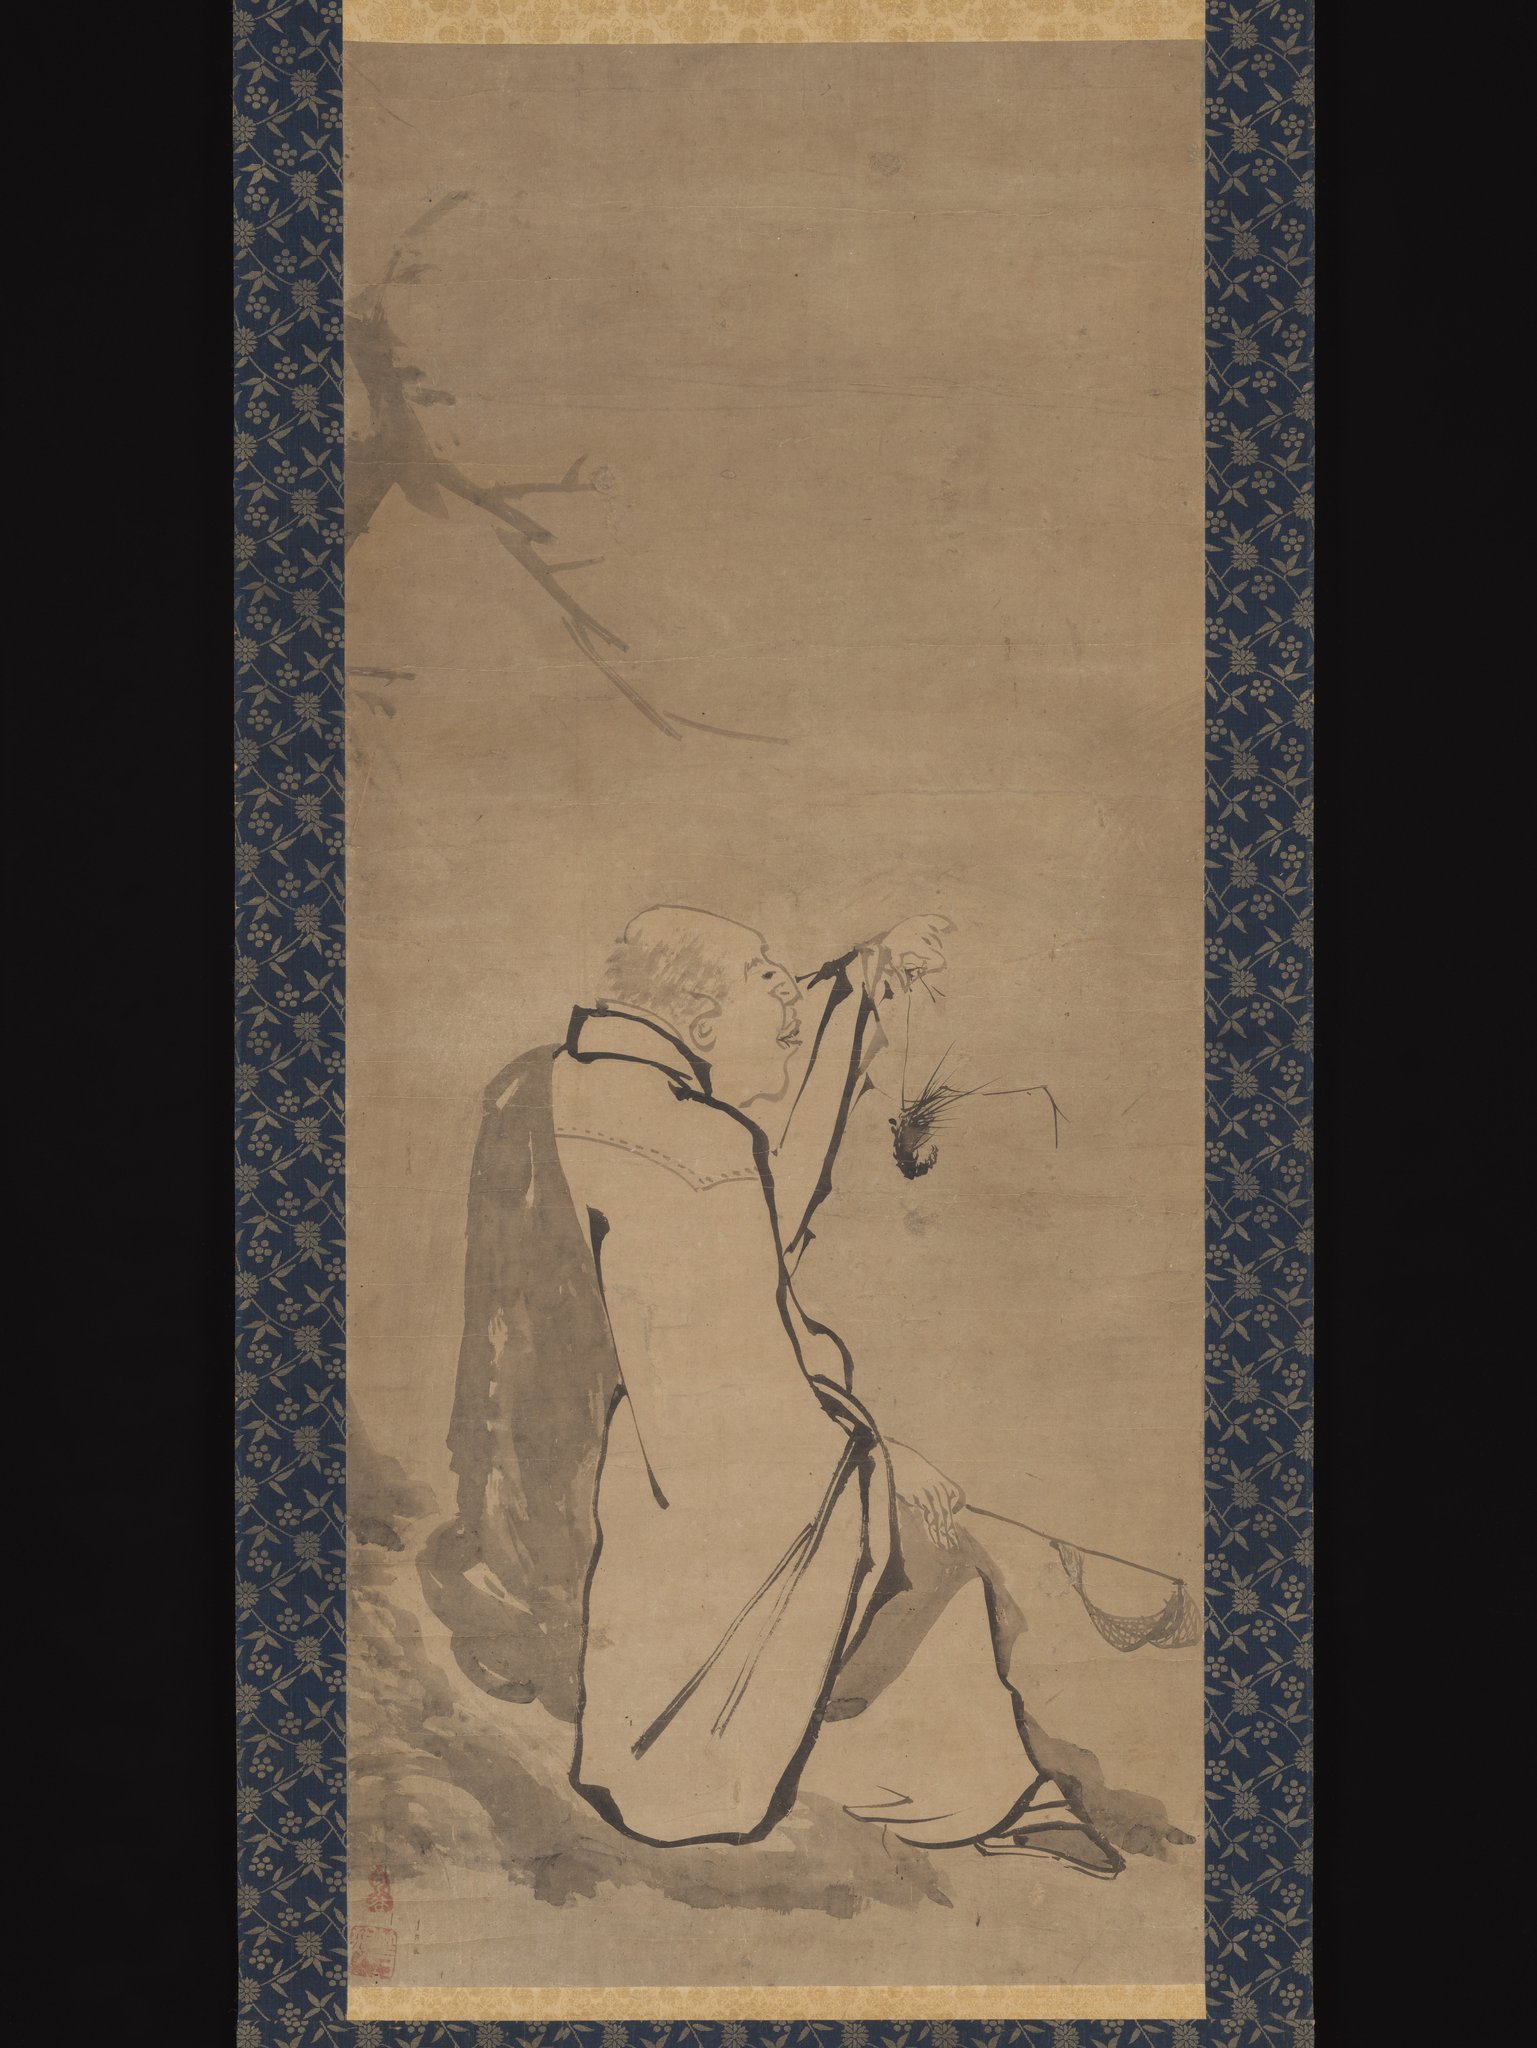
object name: hanging scroll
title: Priest Xianzi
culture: japanese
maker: unkoku tōgan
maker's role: artist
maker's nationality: japanese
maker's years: 1547-1618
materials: ink, silk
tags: monks,crayfish